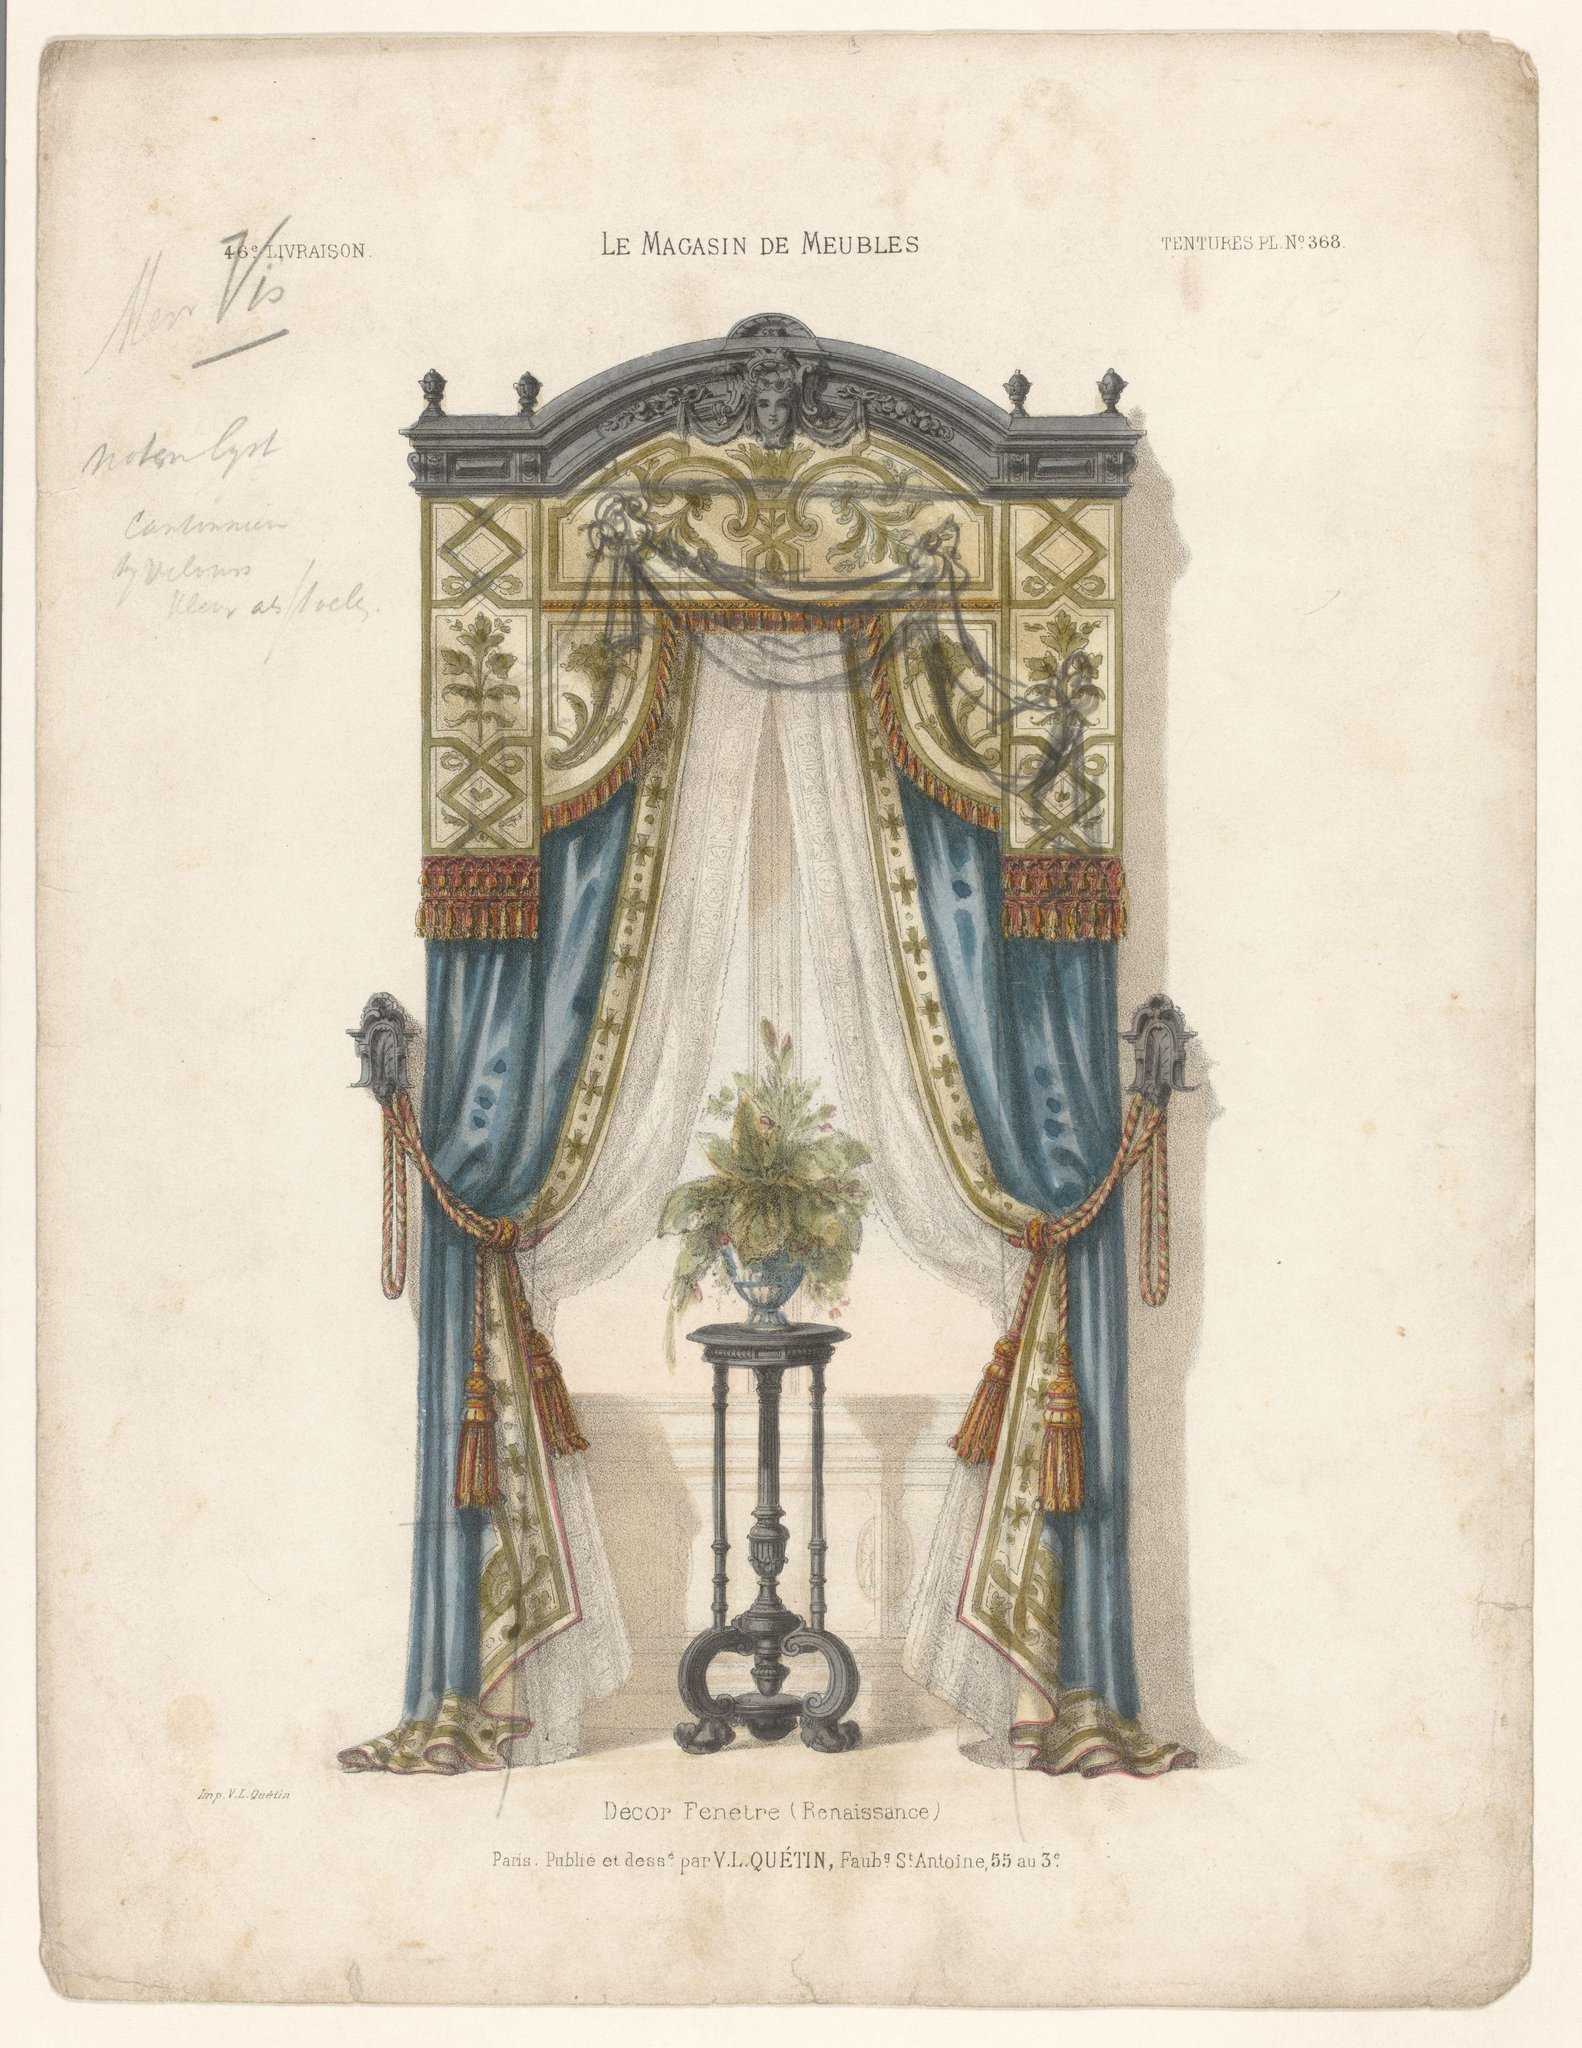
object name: print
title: Venster met gordijnen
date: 1878-1904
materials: paper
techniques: hand coloring, lithograph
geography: paris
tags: window, hangings and drapery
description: Een renaissance venster met gedrapeerde gordijnen. Voor het venster staat een vaas met bloemen op een tafel. Prent uit 46e Livraison.